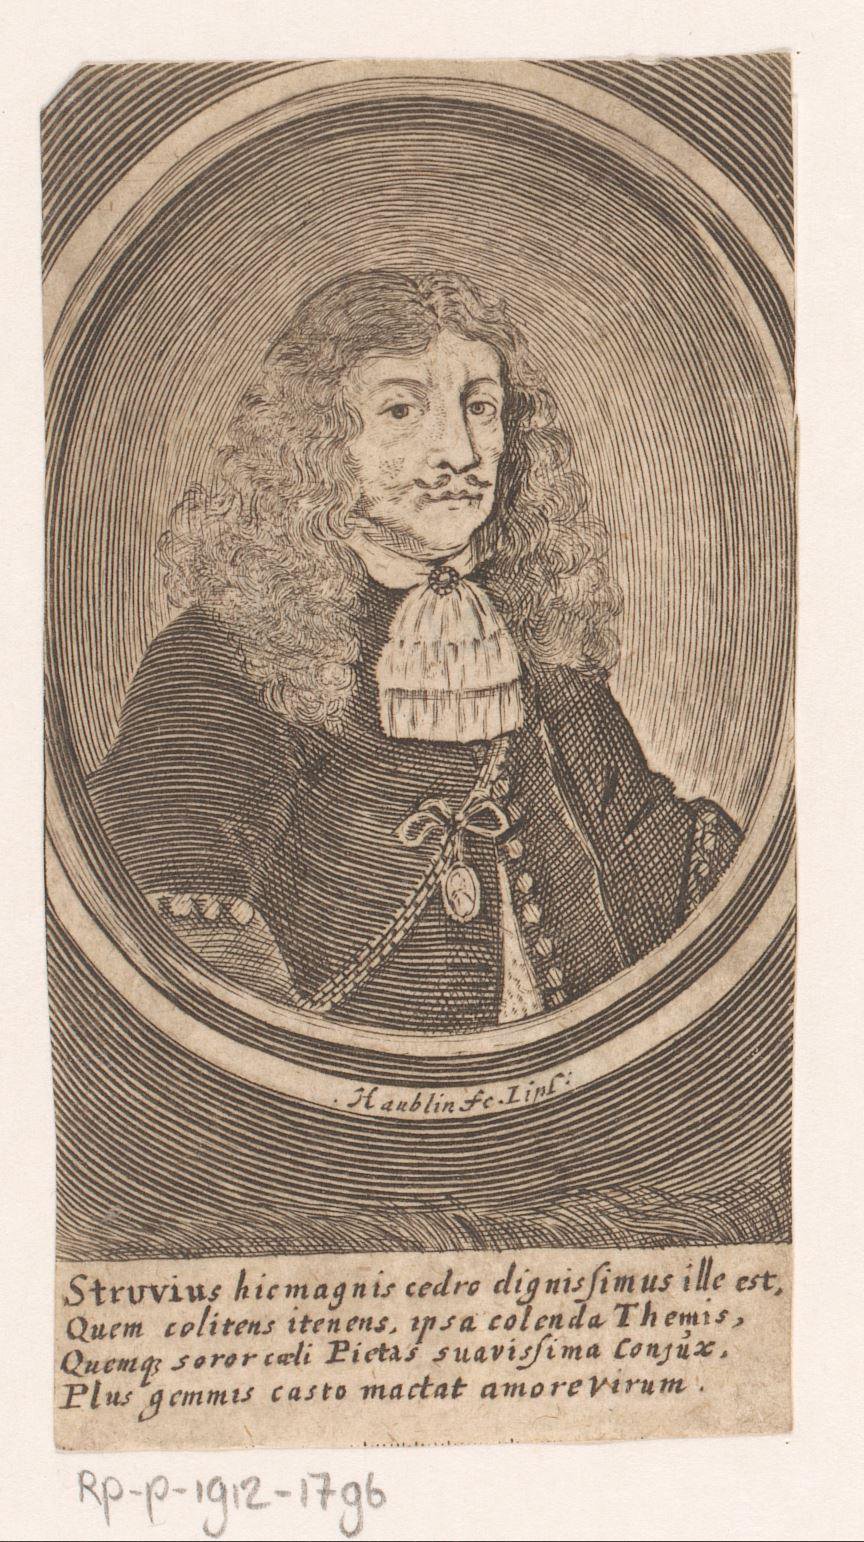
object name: print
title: Portret van Johann Ludwig Hauenreuter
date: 1618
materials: paper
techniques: engraving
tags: cut flowers; nosegay, bunch of flowers, gloves, mittens, etc., historical persons, pendant, trinket, 'breloque', book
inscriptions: collector's mark: Lugt 2228